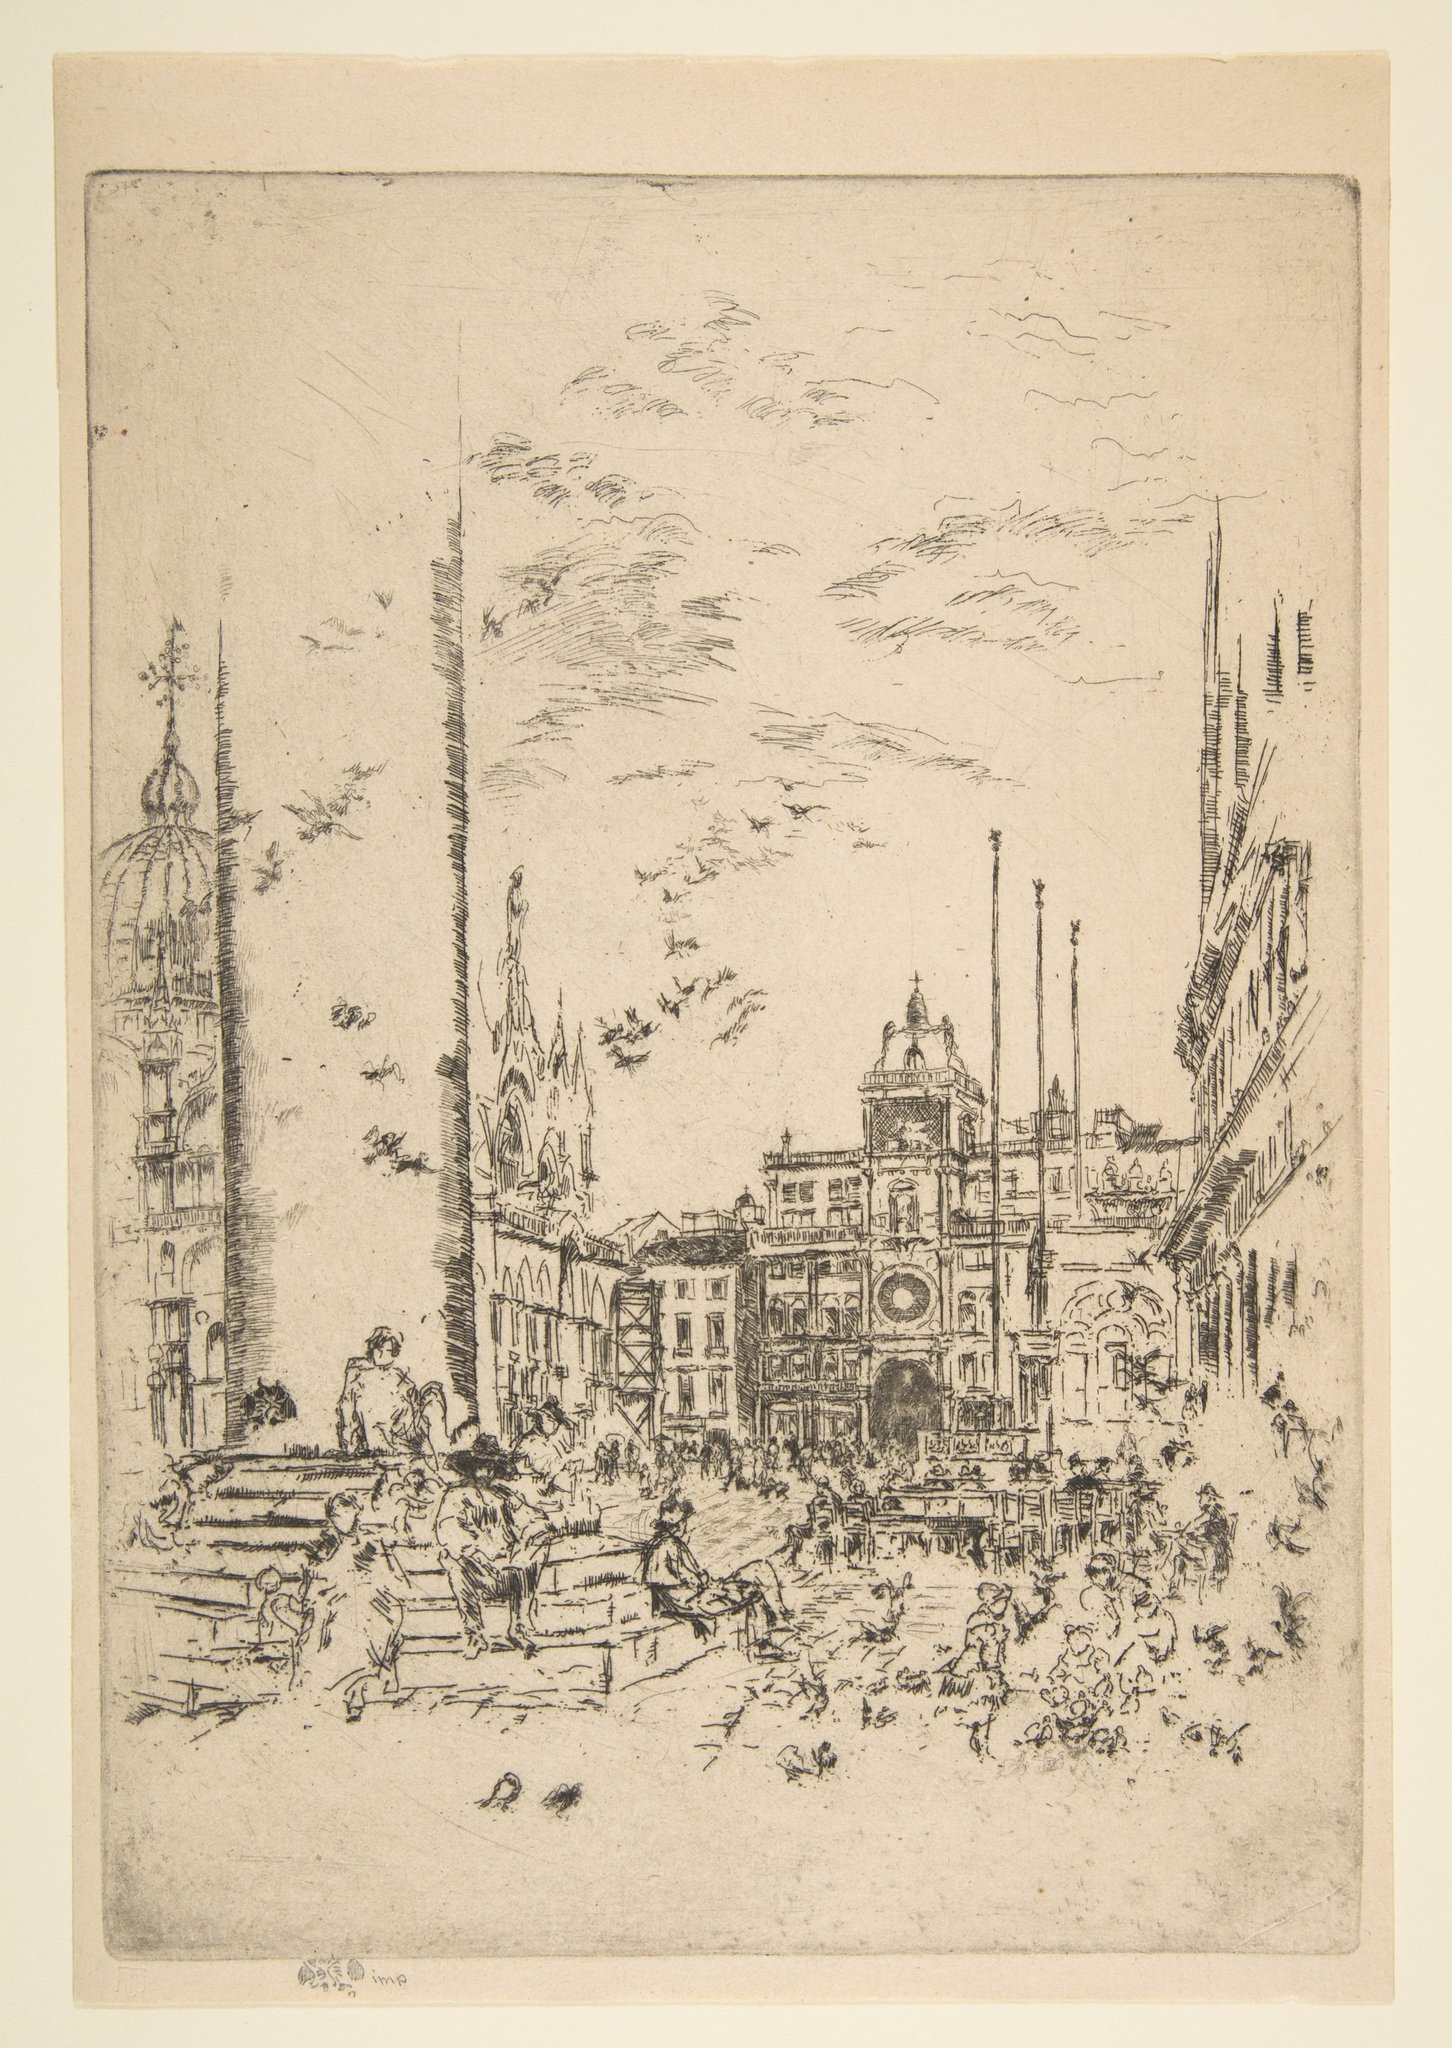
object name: print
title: The Piazetta (The Piazzetta)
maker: james mcneill whistler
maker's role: artist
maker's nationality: american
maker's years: 1834-1903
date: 1879-1880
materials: ink, paper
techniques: drypoint, etching, printing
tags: human figures,buildings,venice